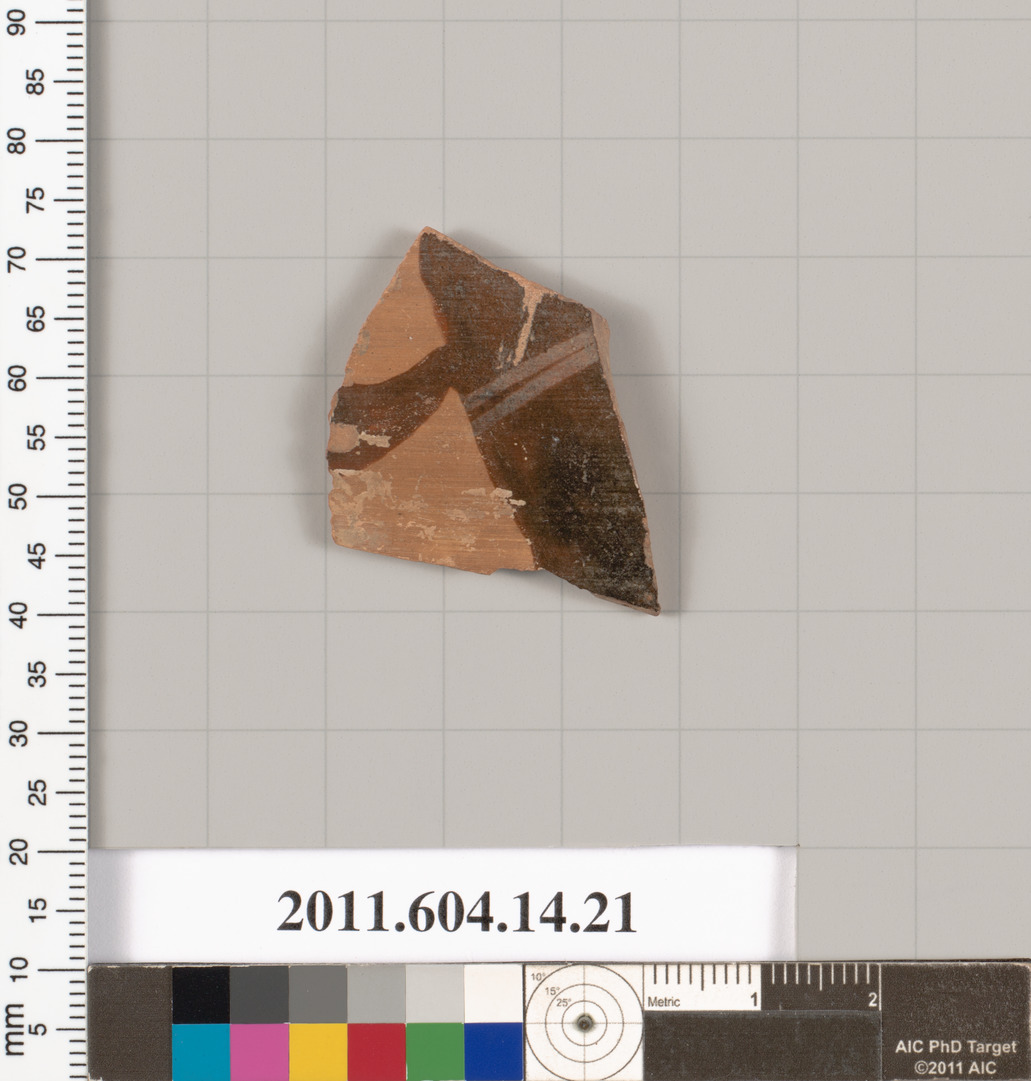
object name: undetermined closed shape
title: Terracotta fragment of an undetermined closed shape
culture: unknown fabric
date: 600-501 BCE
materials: terracotta